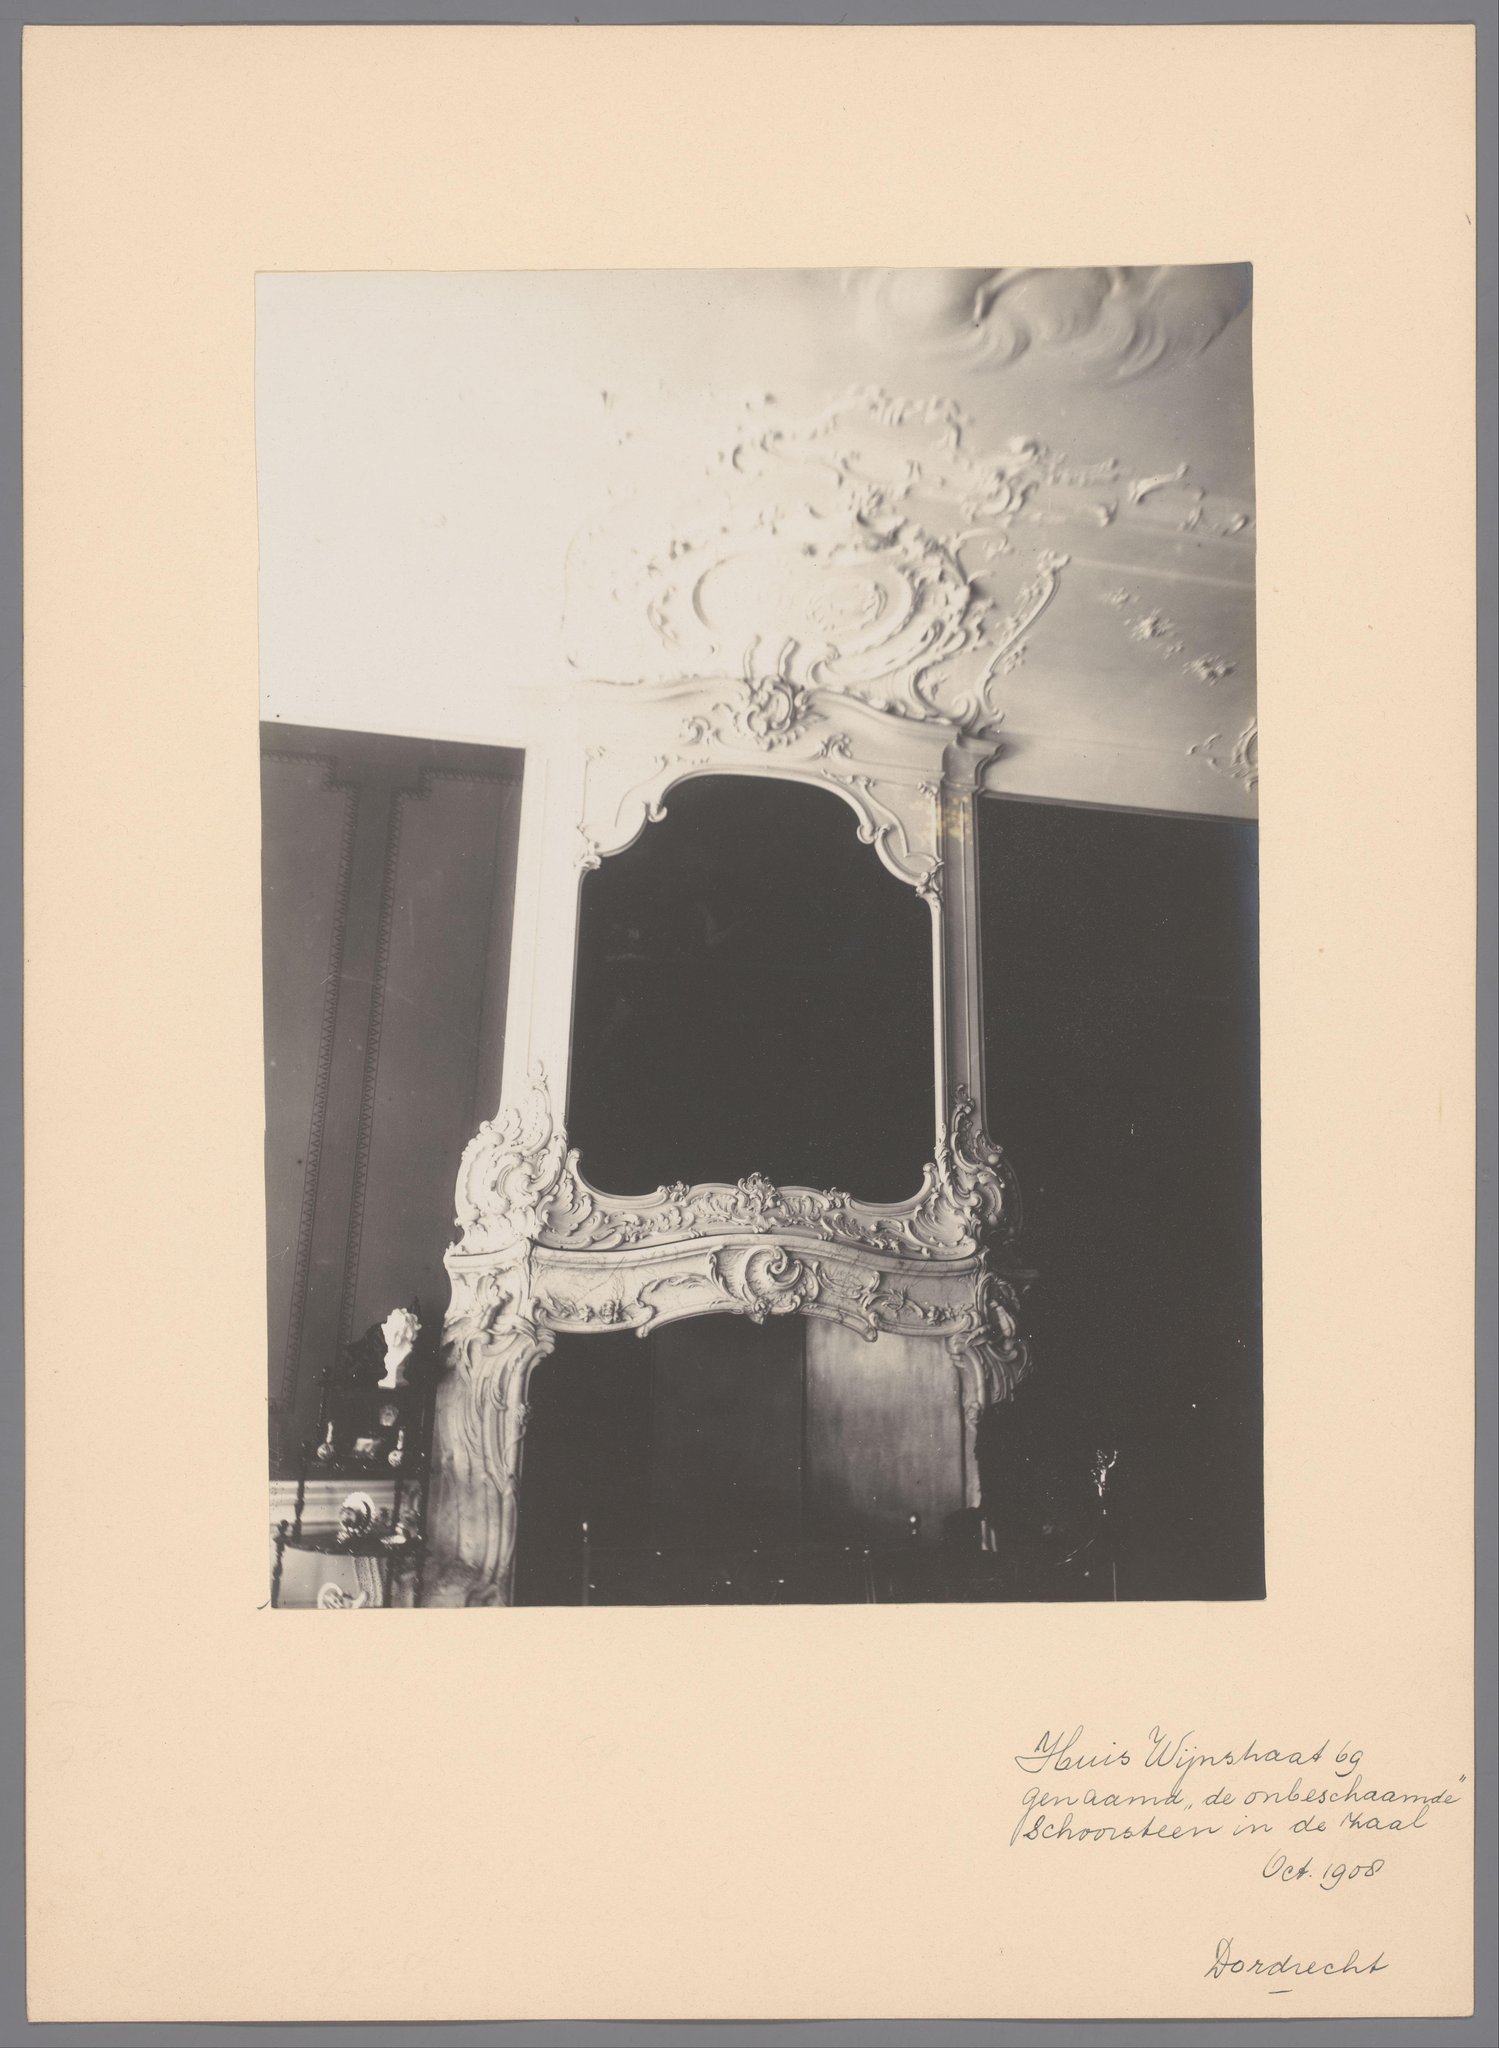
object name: photograph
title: Marmeren schoorsteenmantel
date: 1908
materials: cardboard, photographic support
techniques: gelatin silver print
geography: wijnstraat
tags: open hearth, fire-place, interior of the house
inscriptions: annotation: ‘Huis Wijnstraat 69 genaamd "de onbeschaamde"/ schoorsteen in de zaal/ Oct. 1908/ Dordrecht’